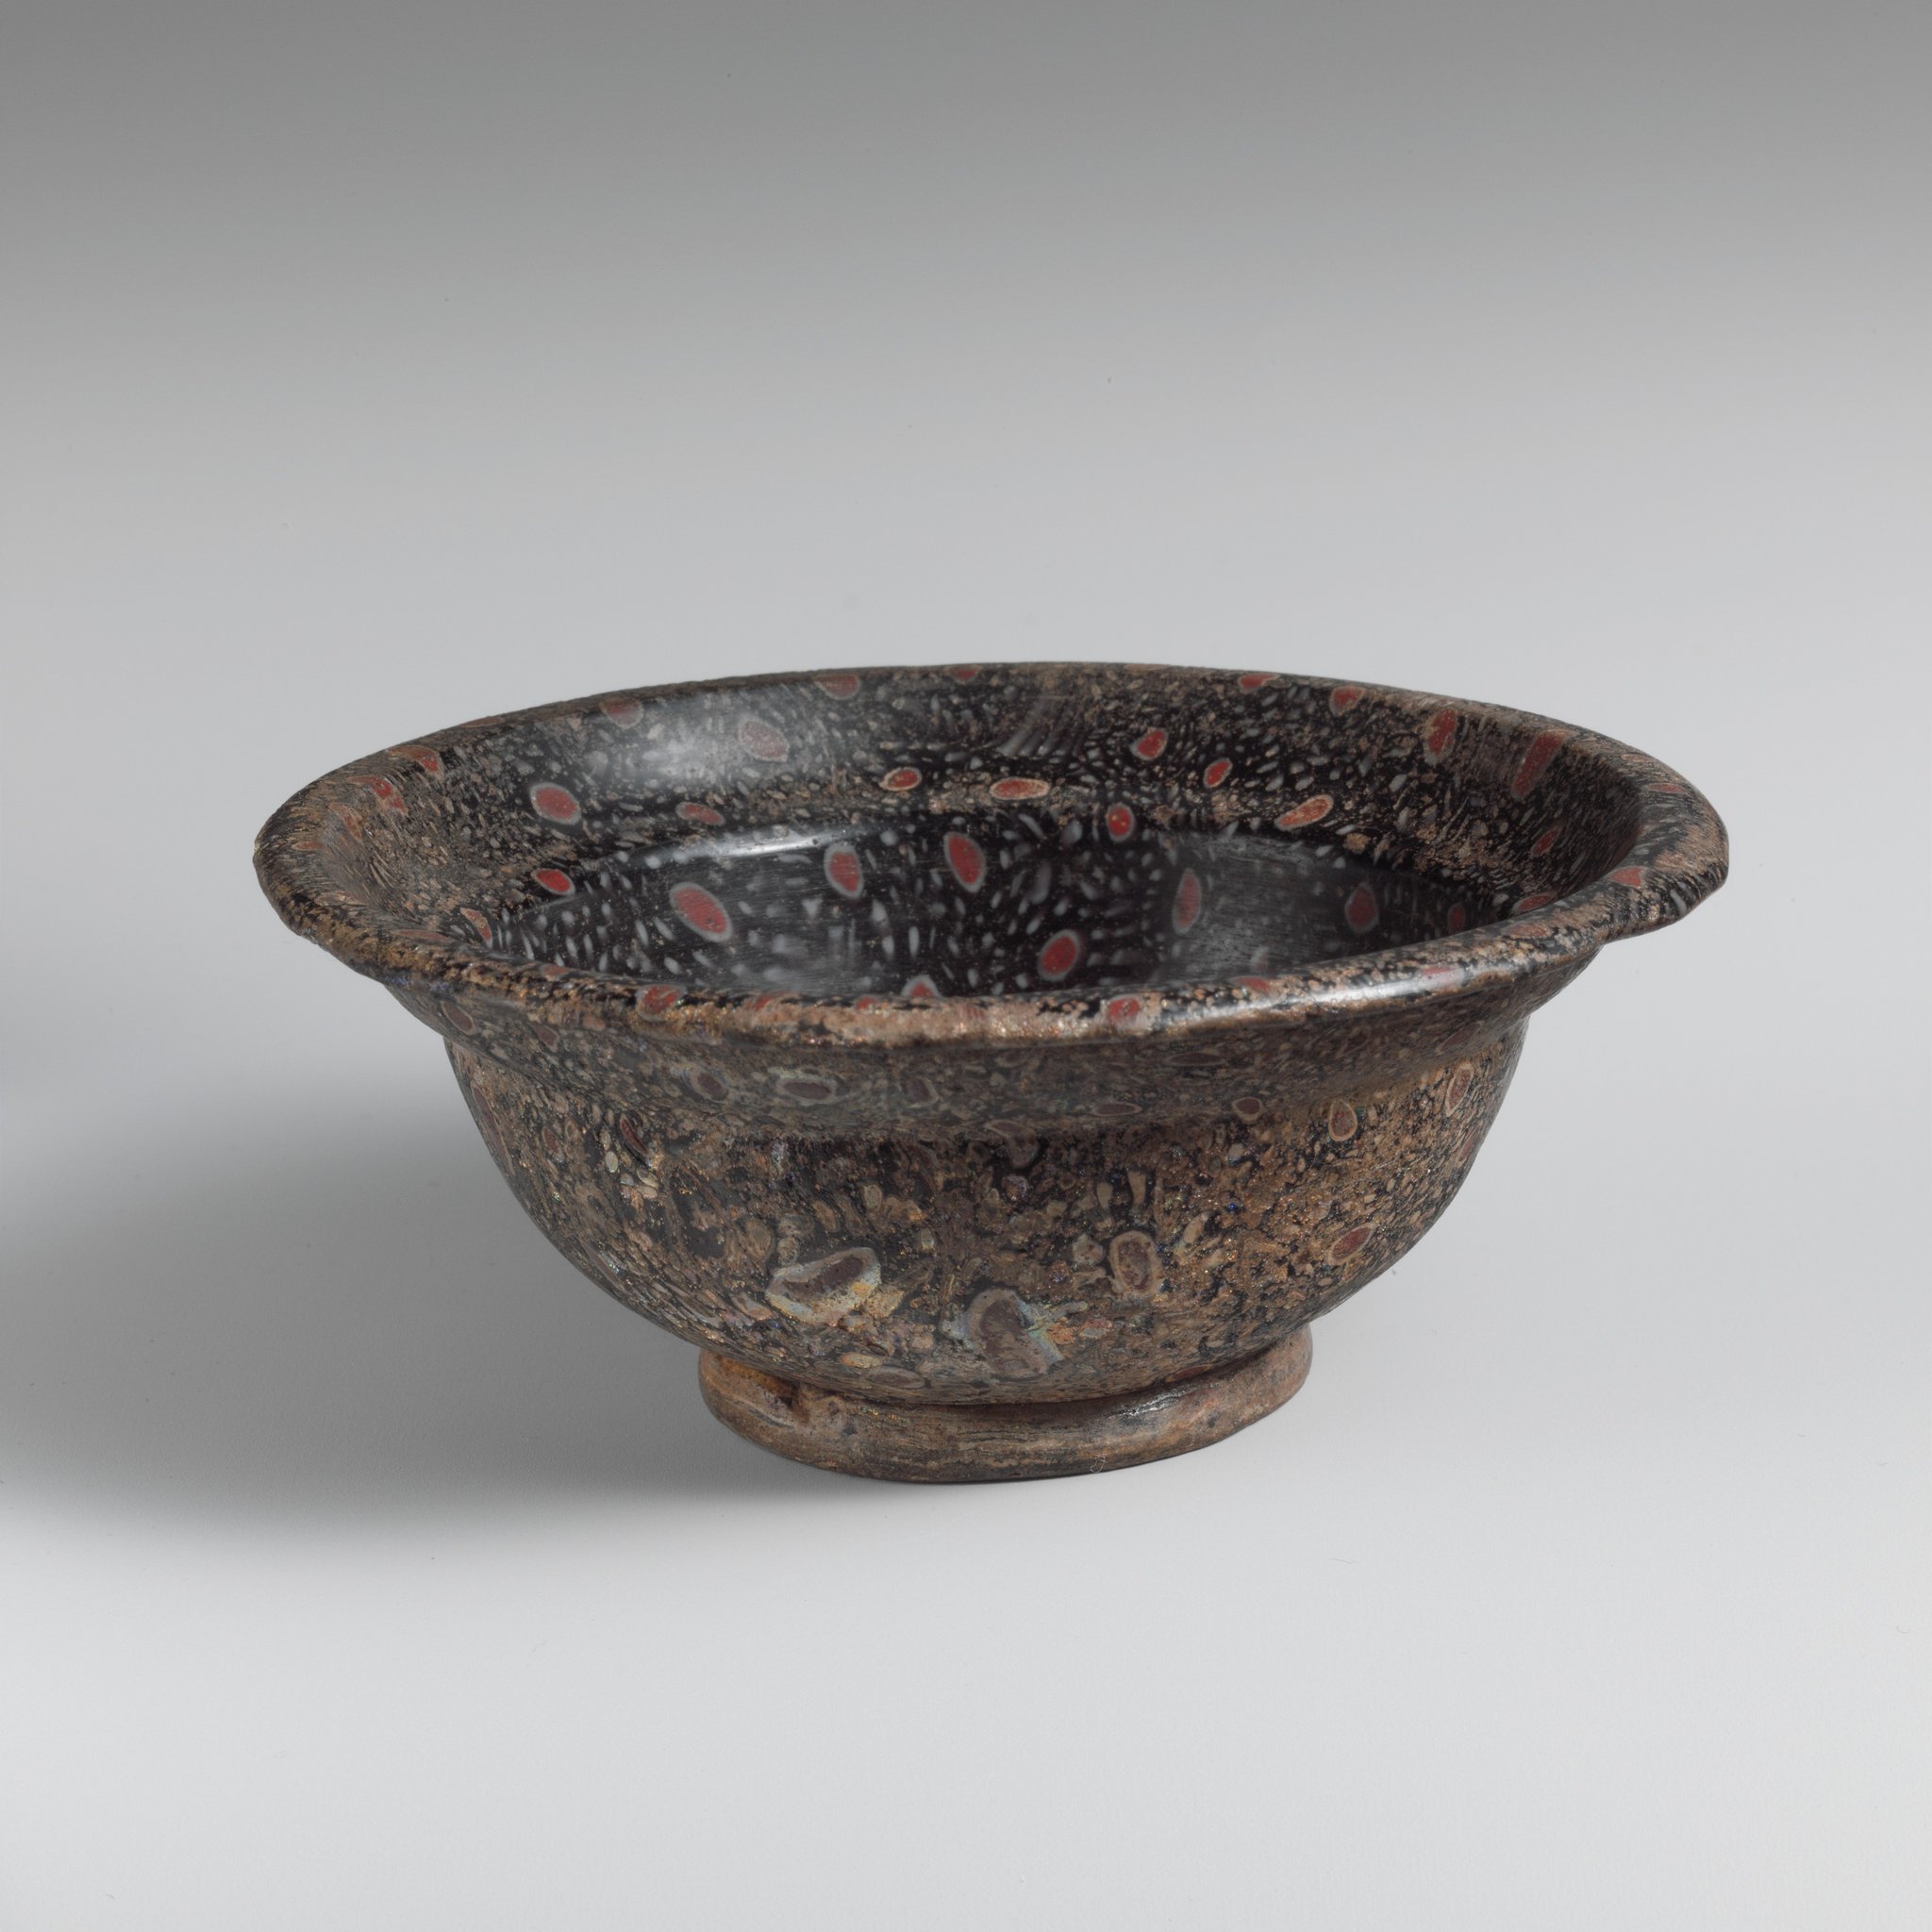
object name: bowl, mosaic, patella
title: Glass mosaic bowl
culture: roman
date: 34 BCE-33 CE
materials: glass